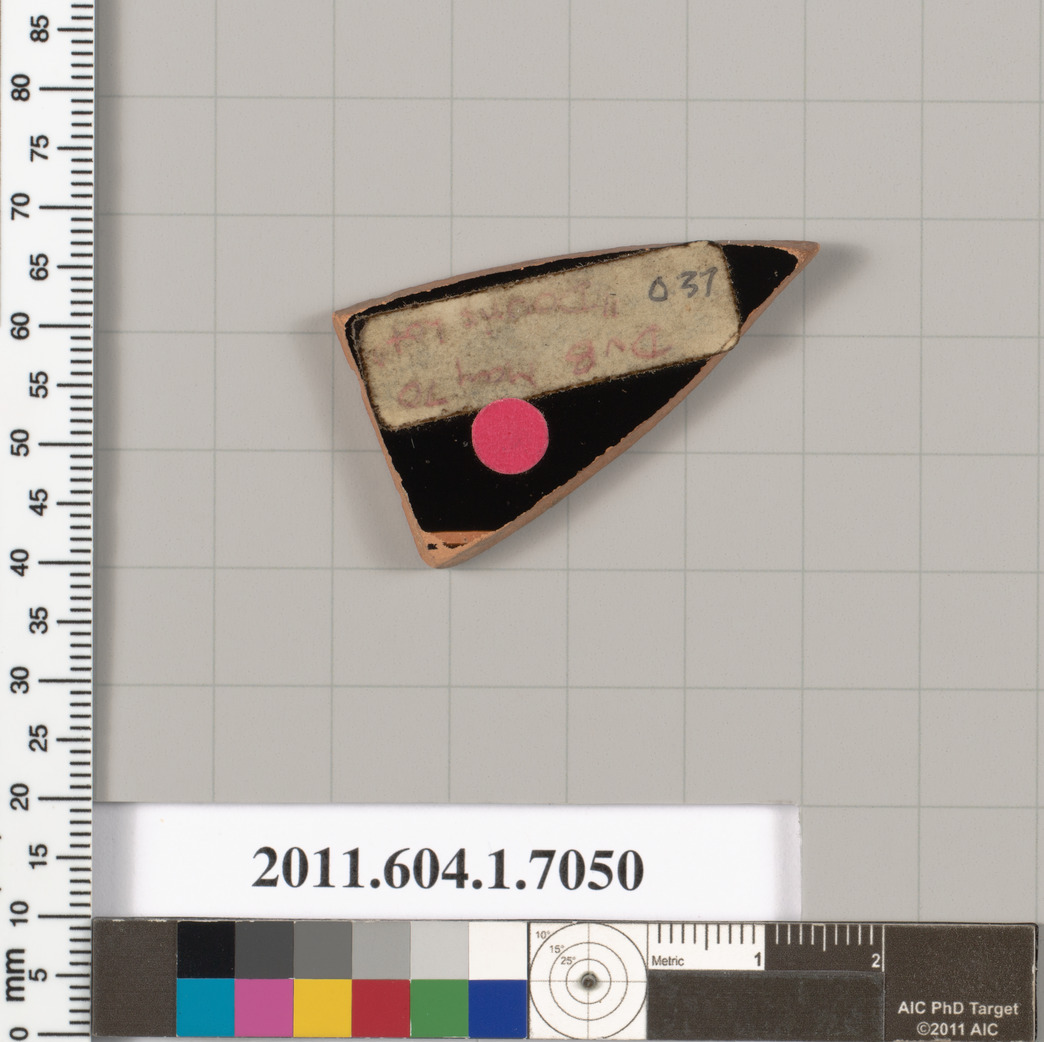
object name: kylix fragment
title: Terracotta fragment of a kylix (drinking cup)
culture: greek, attic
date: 500-480 BCE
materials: terracotta